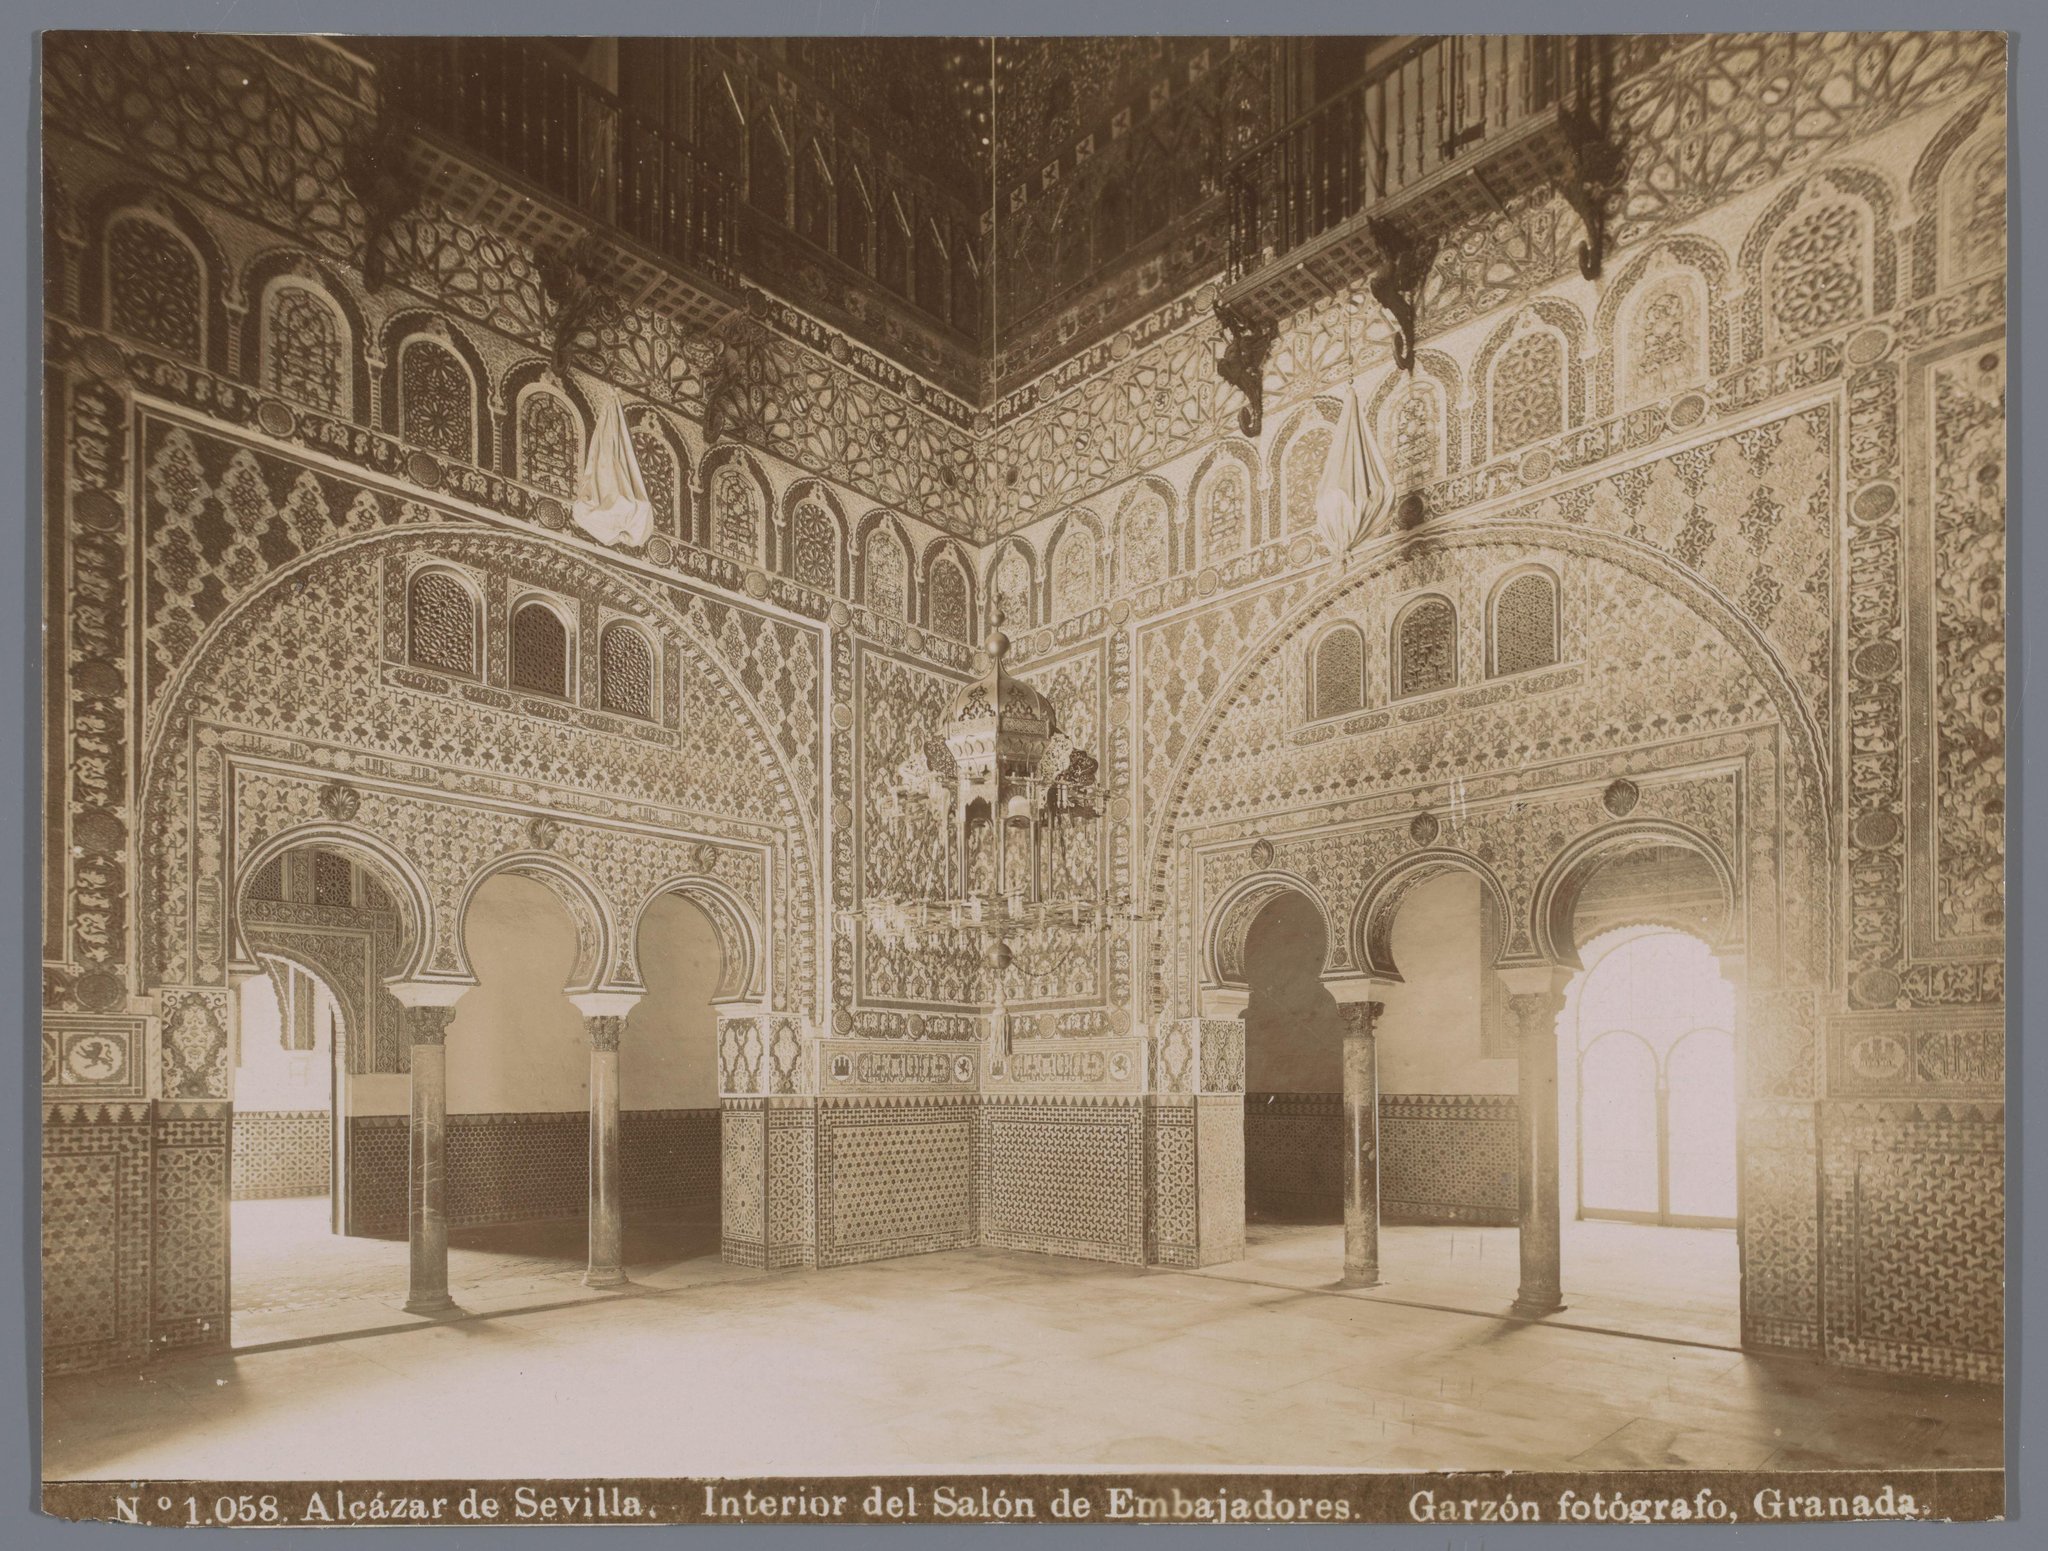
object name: photograph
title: Alcazar de Sevilla, interior del Salón de Embajadores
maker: rafael garzón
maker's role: publisher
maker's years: 1863-1923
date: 1880-1900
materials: paper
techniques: albumen print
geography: sevilla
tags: palace - aa - civic architecture: inside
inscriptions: number: ‘No 1.058.’